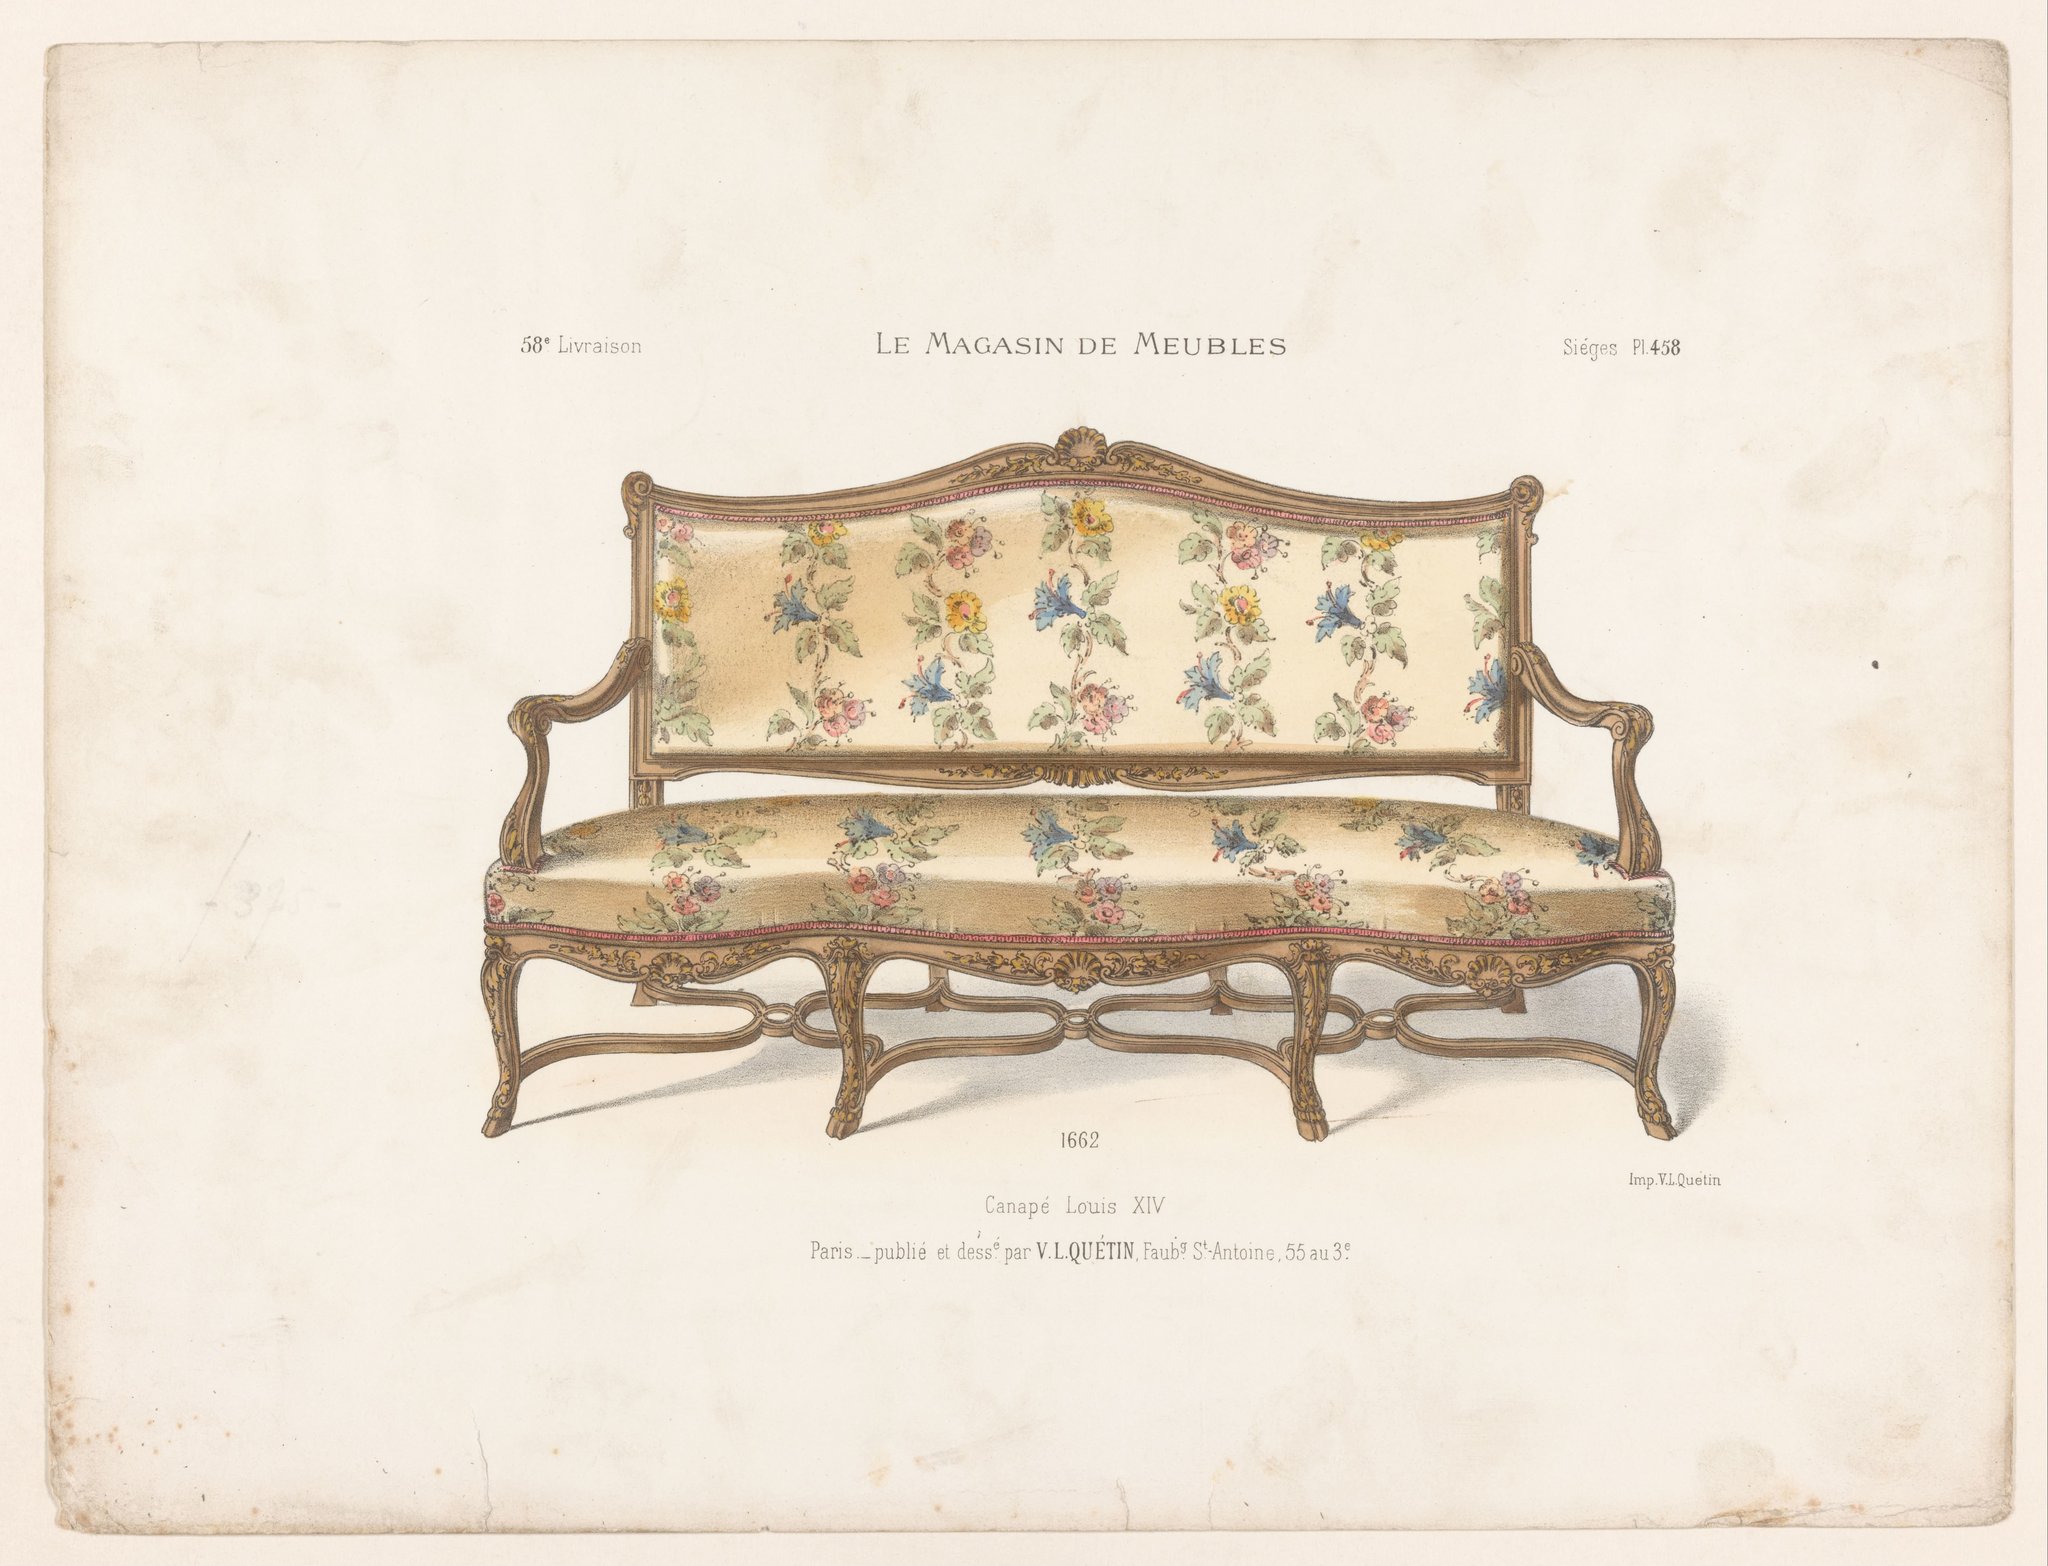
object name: print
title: Canapé Louis XIV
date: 1878-1904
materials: paper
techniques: hand coloring, lithograph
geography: paris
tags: seating furniture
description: Een canapé in de Lodewijk XIV-stijl. Prent uit 58e Livraison.